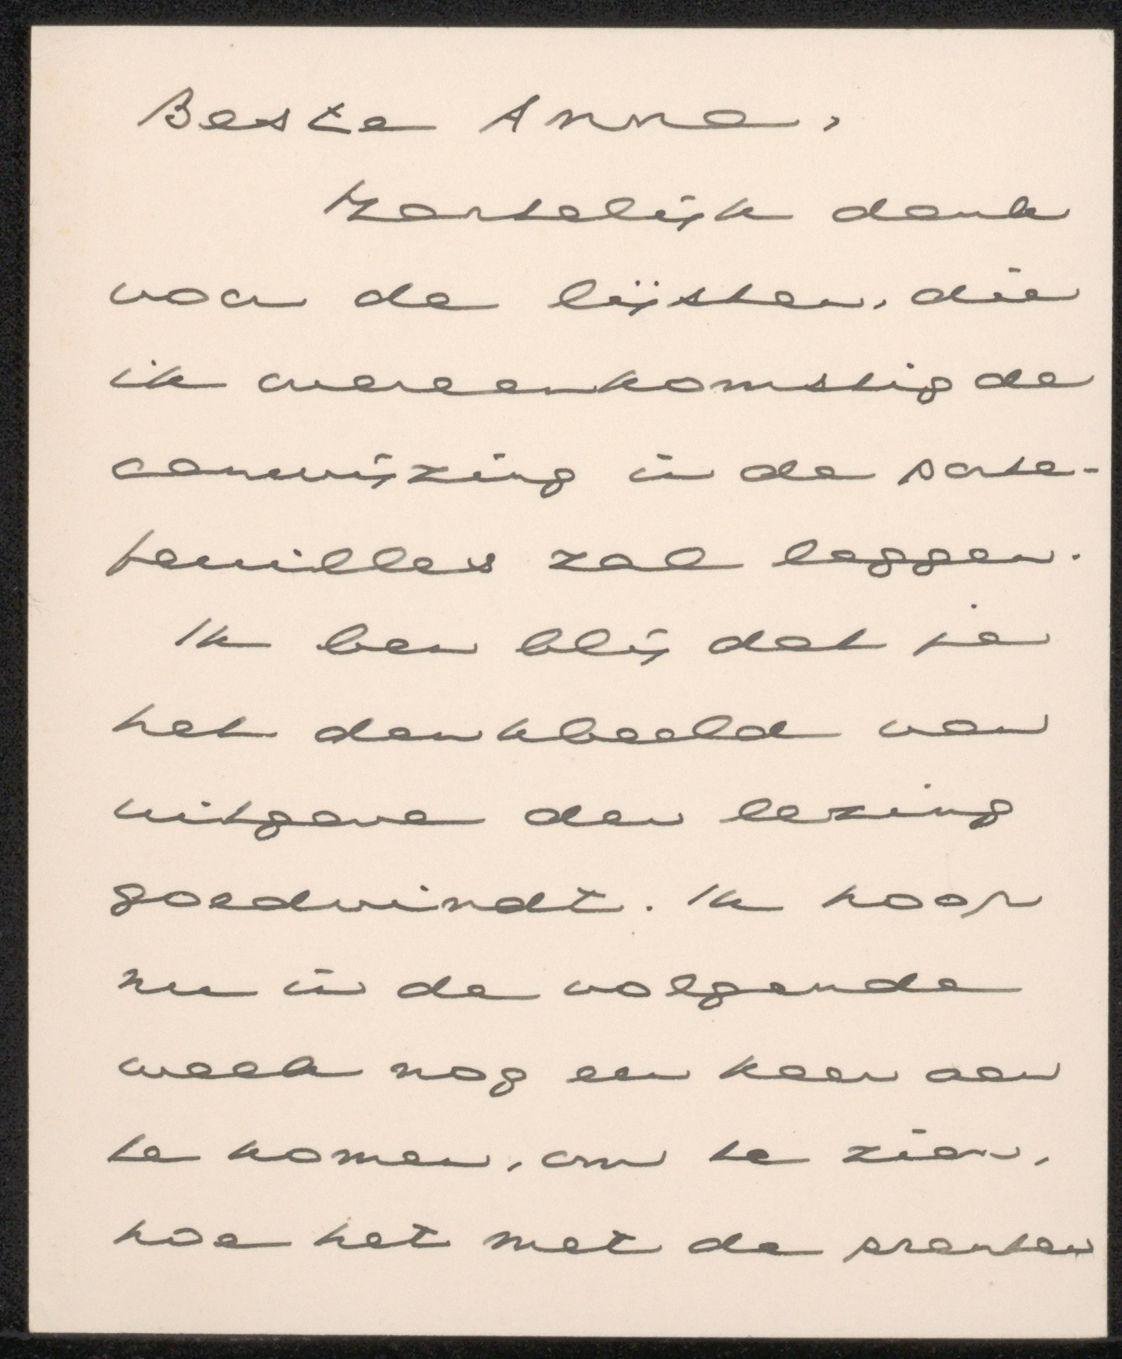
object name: letter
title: Brief aan Anna Dorothea Dirks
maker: johan huizinga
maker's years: 1872-1945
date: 1927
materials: ink, paper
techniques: pen, writing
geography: leiden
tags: artist, anna dorothea dirks, publisher, hermanus diedericus tjeenk willink (1843-1917), the graphic arts, printed matter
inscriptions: collector's mark: ‘RPK’